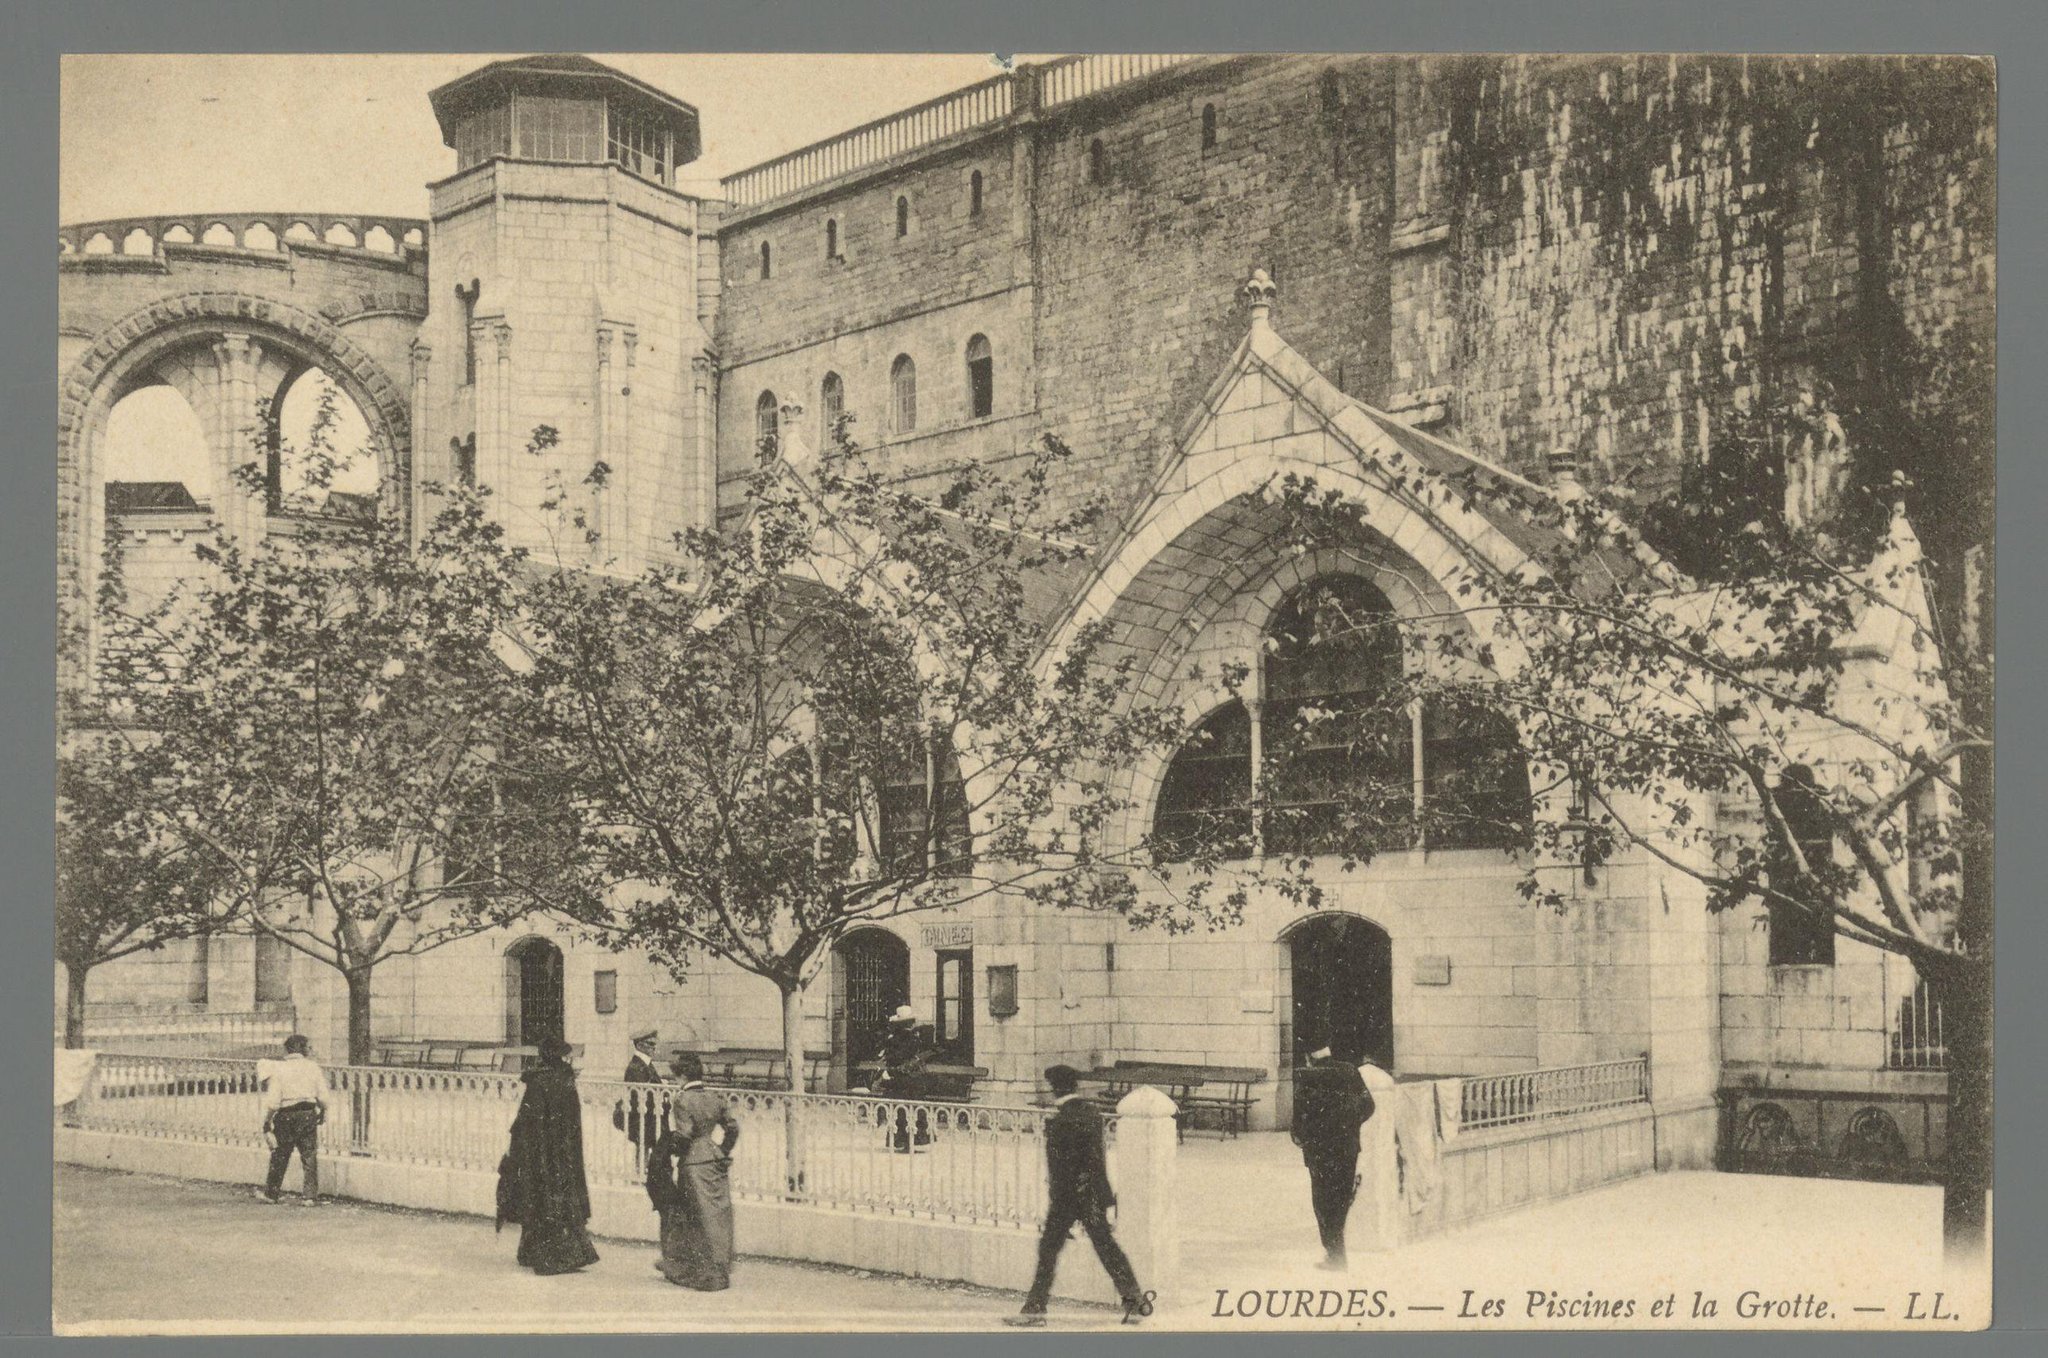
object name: ansichtkaart, prentbriefkaart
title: Lourdes. Les Piscines et la Grotte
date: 1904-1906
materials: cardboard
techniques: photograph, writing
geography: paris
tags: gate, entrance, city-view, and landscape with man-made constructions (+ city(-scape) with figures, staffage)